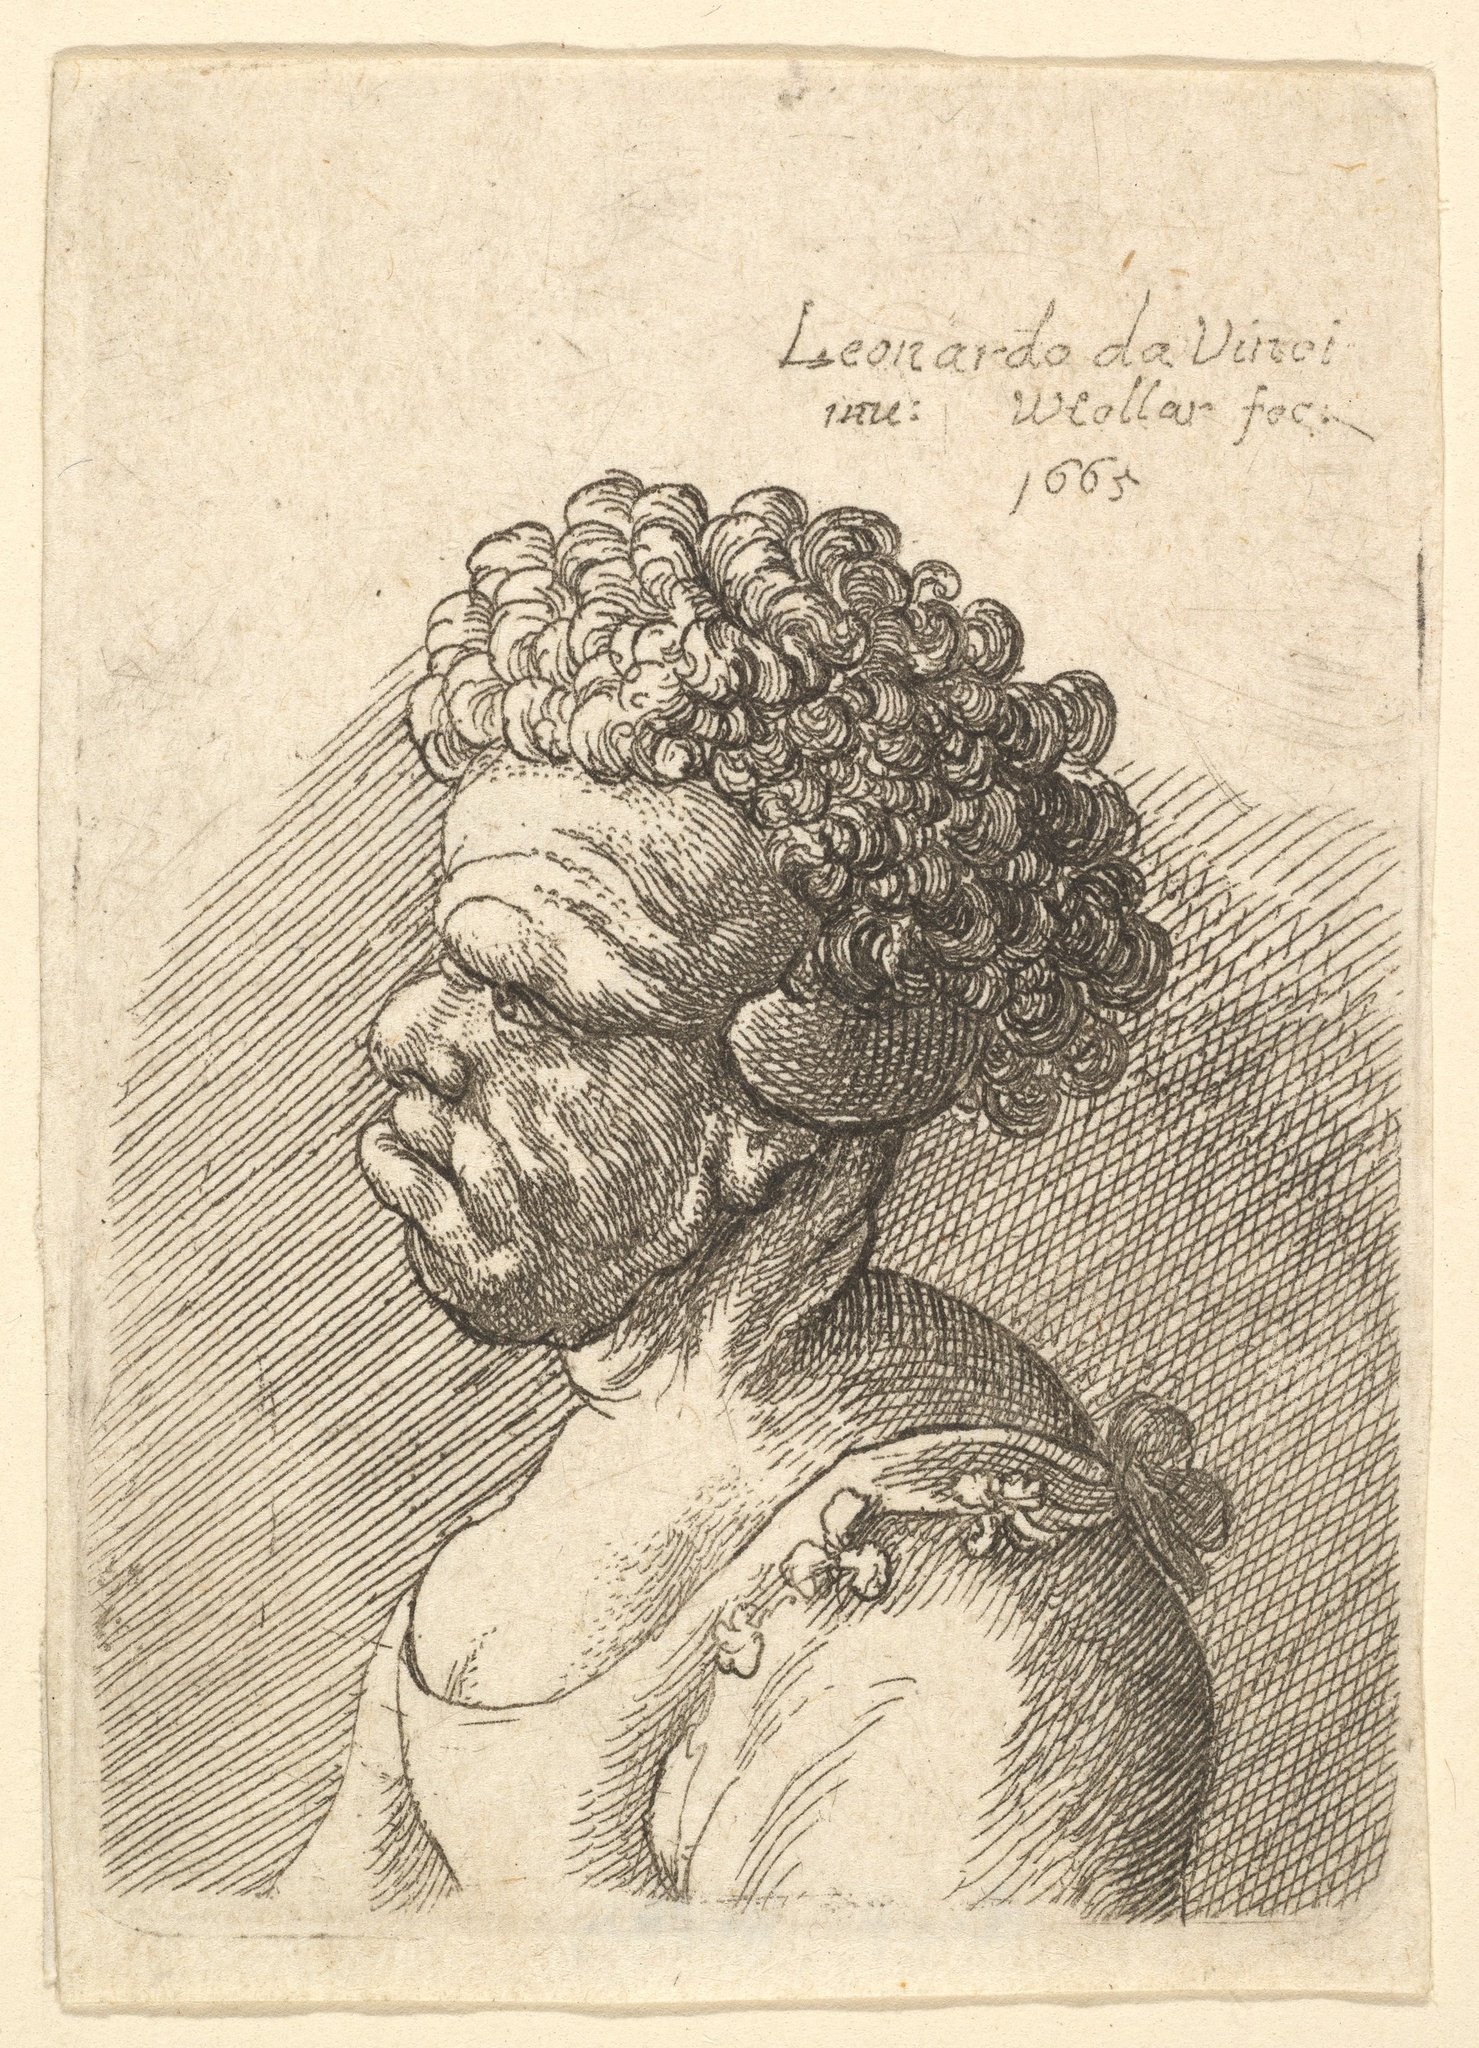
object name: print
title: Bust of a deformed woman with curly hair in profile to the left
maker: wenceslaus hollar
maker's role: artist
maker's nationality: bohemian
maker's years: 1607-1677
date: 1665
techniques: etching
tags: profiles,women